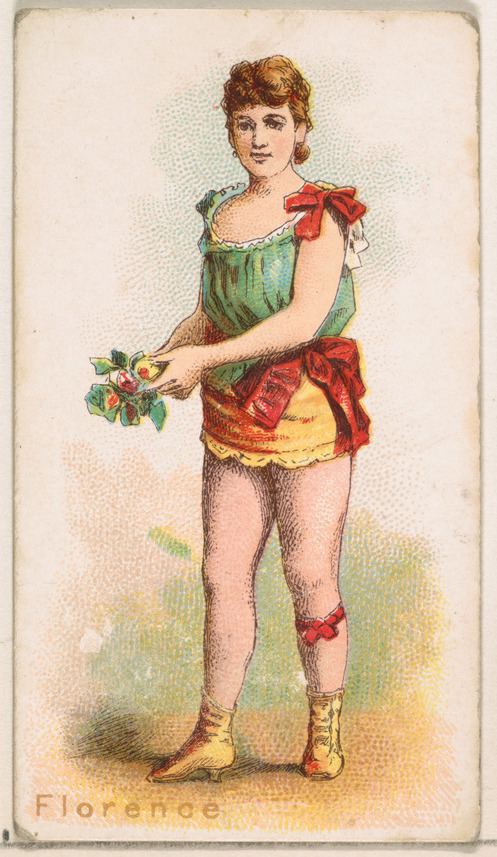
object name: print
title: Florence, from the Ballet Queens series (N182) issued by Wm. S. Kimball & Co.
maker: william s. kimball & company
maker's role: publisher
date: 1889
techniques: color lithograph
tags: women,dancers